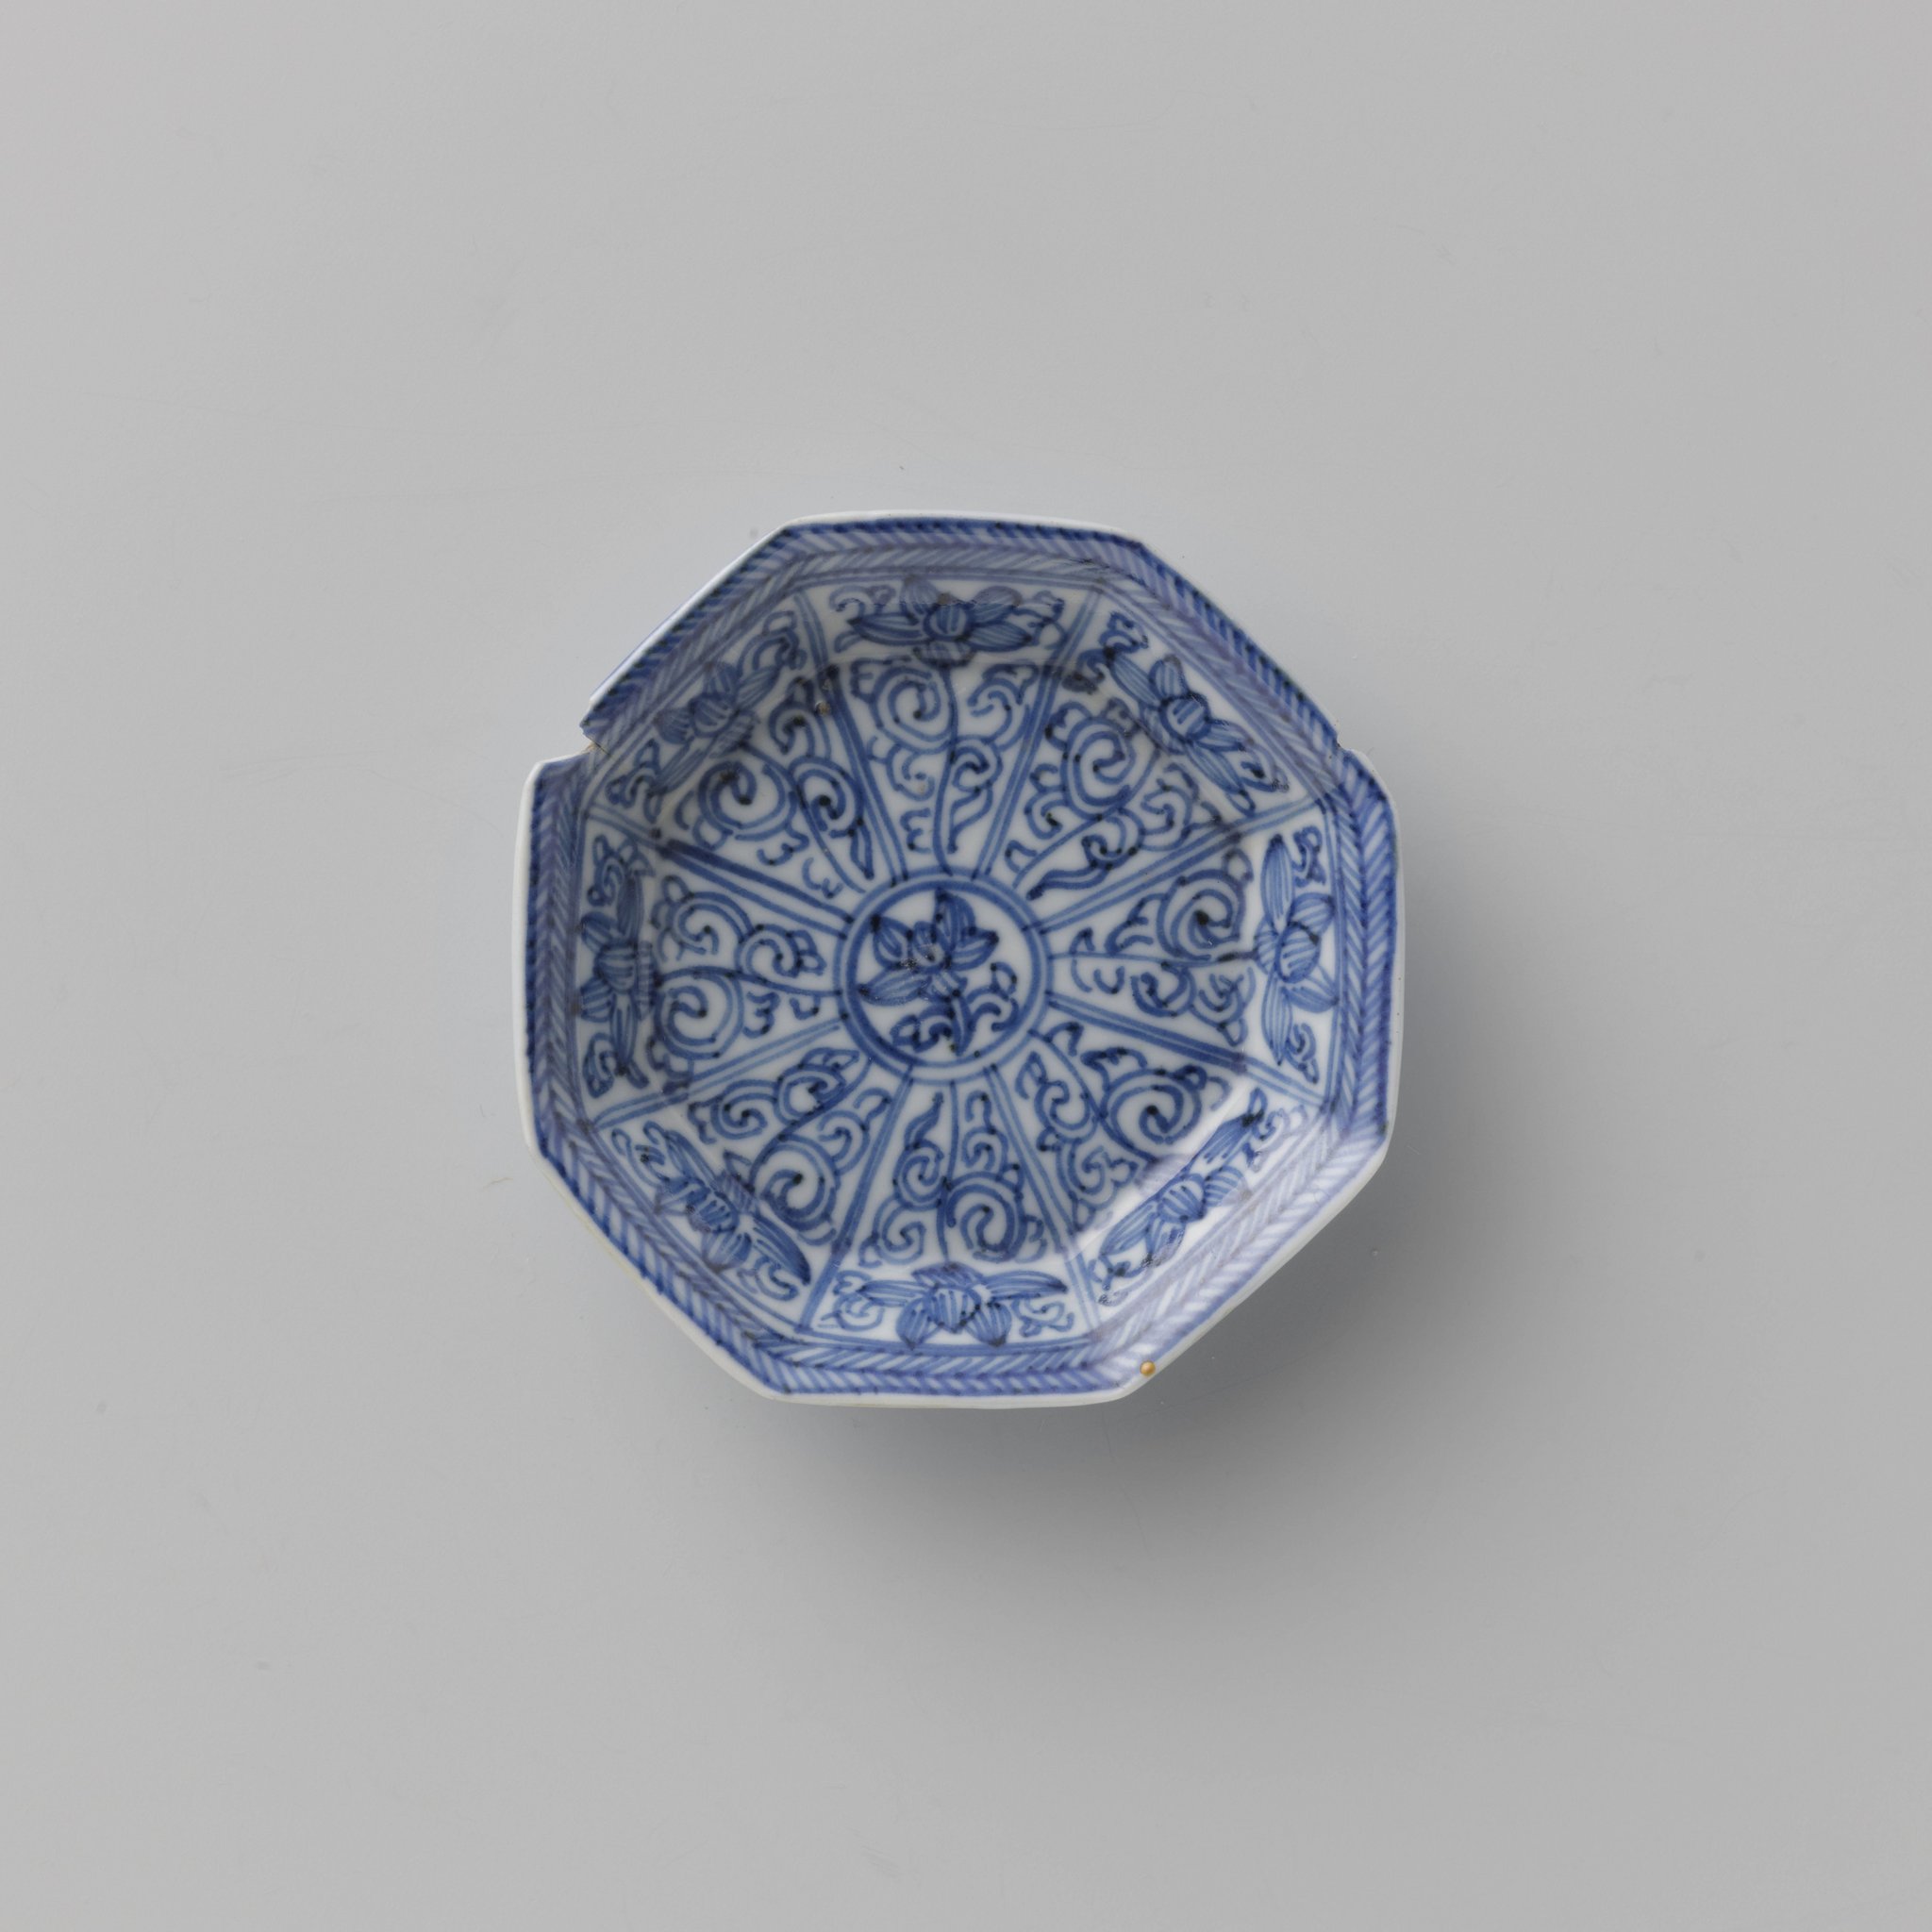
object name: platter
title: Octagonal saucer with lotus scrolls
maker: Anonymous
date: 1700-1724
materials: cobalt, glaze, paint, porcelain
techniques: firing, forming, turning, vitrification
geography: china